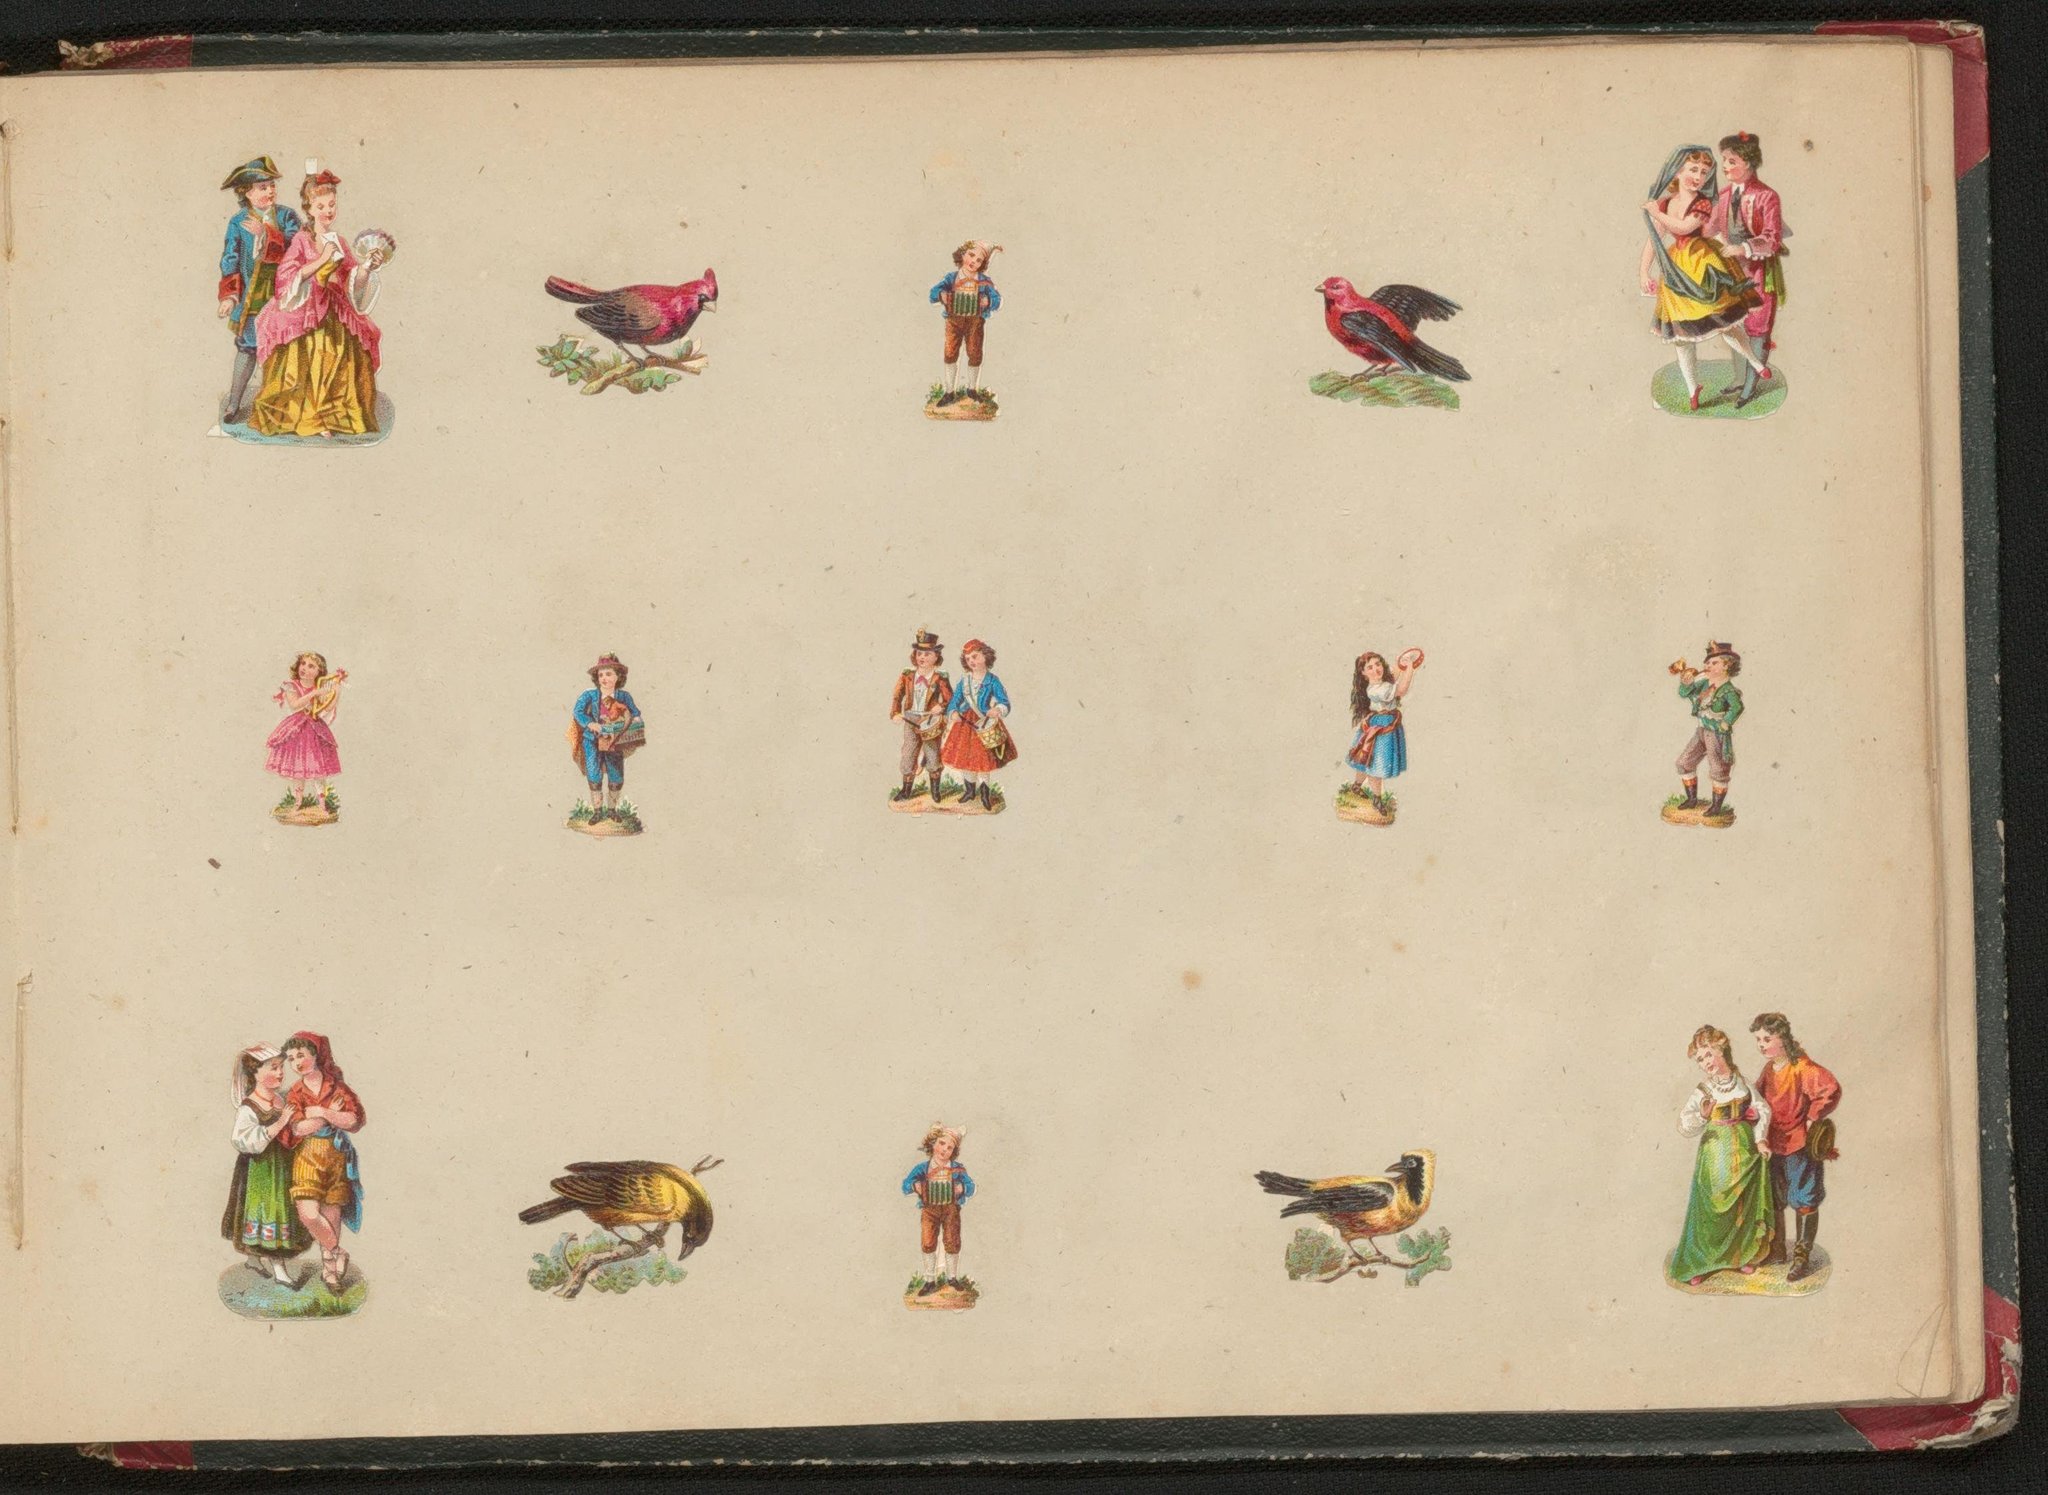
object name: album leaf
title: Albumblad met 15 plakplaatjes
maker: Anonymous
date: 1880-1910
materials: paper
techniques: chromolithography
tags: children's games and plays, birds, couple of lovers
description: Albumblad met 15 plakplaatjes van kinderen, vogels en liefdesparen. Onderdeel van het plakboek met 38 bladen gevuld met plakplaatjes, poesieplaatjes en uitgeknipte en ingeplakte fragmenten van prenten. Onderwerpsrubrieken binnen de Atlas Zeden en Gewoonten: Schoone kunsten, Varia.